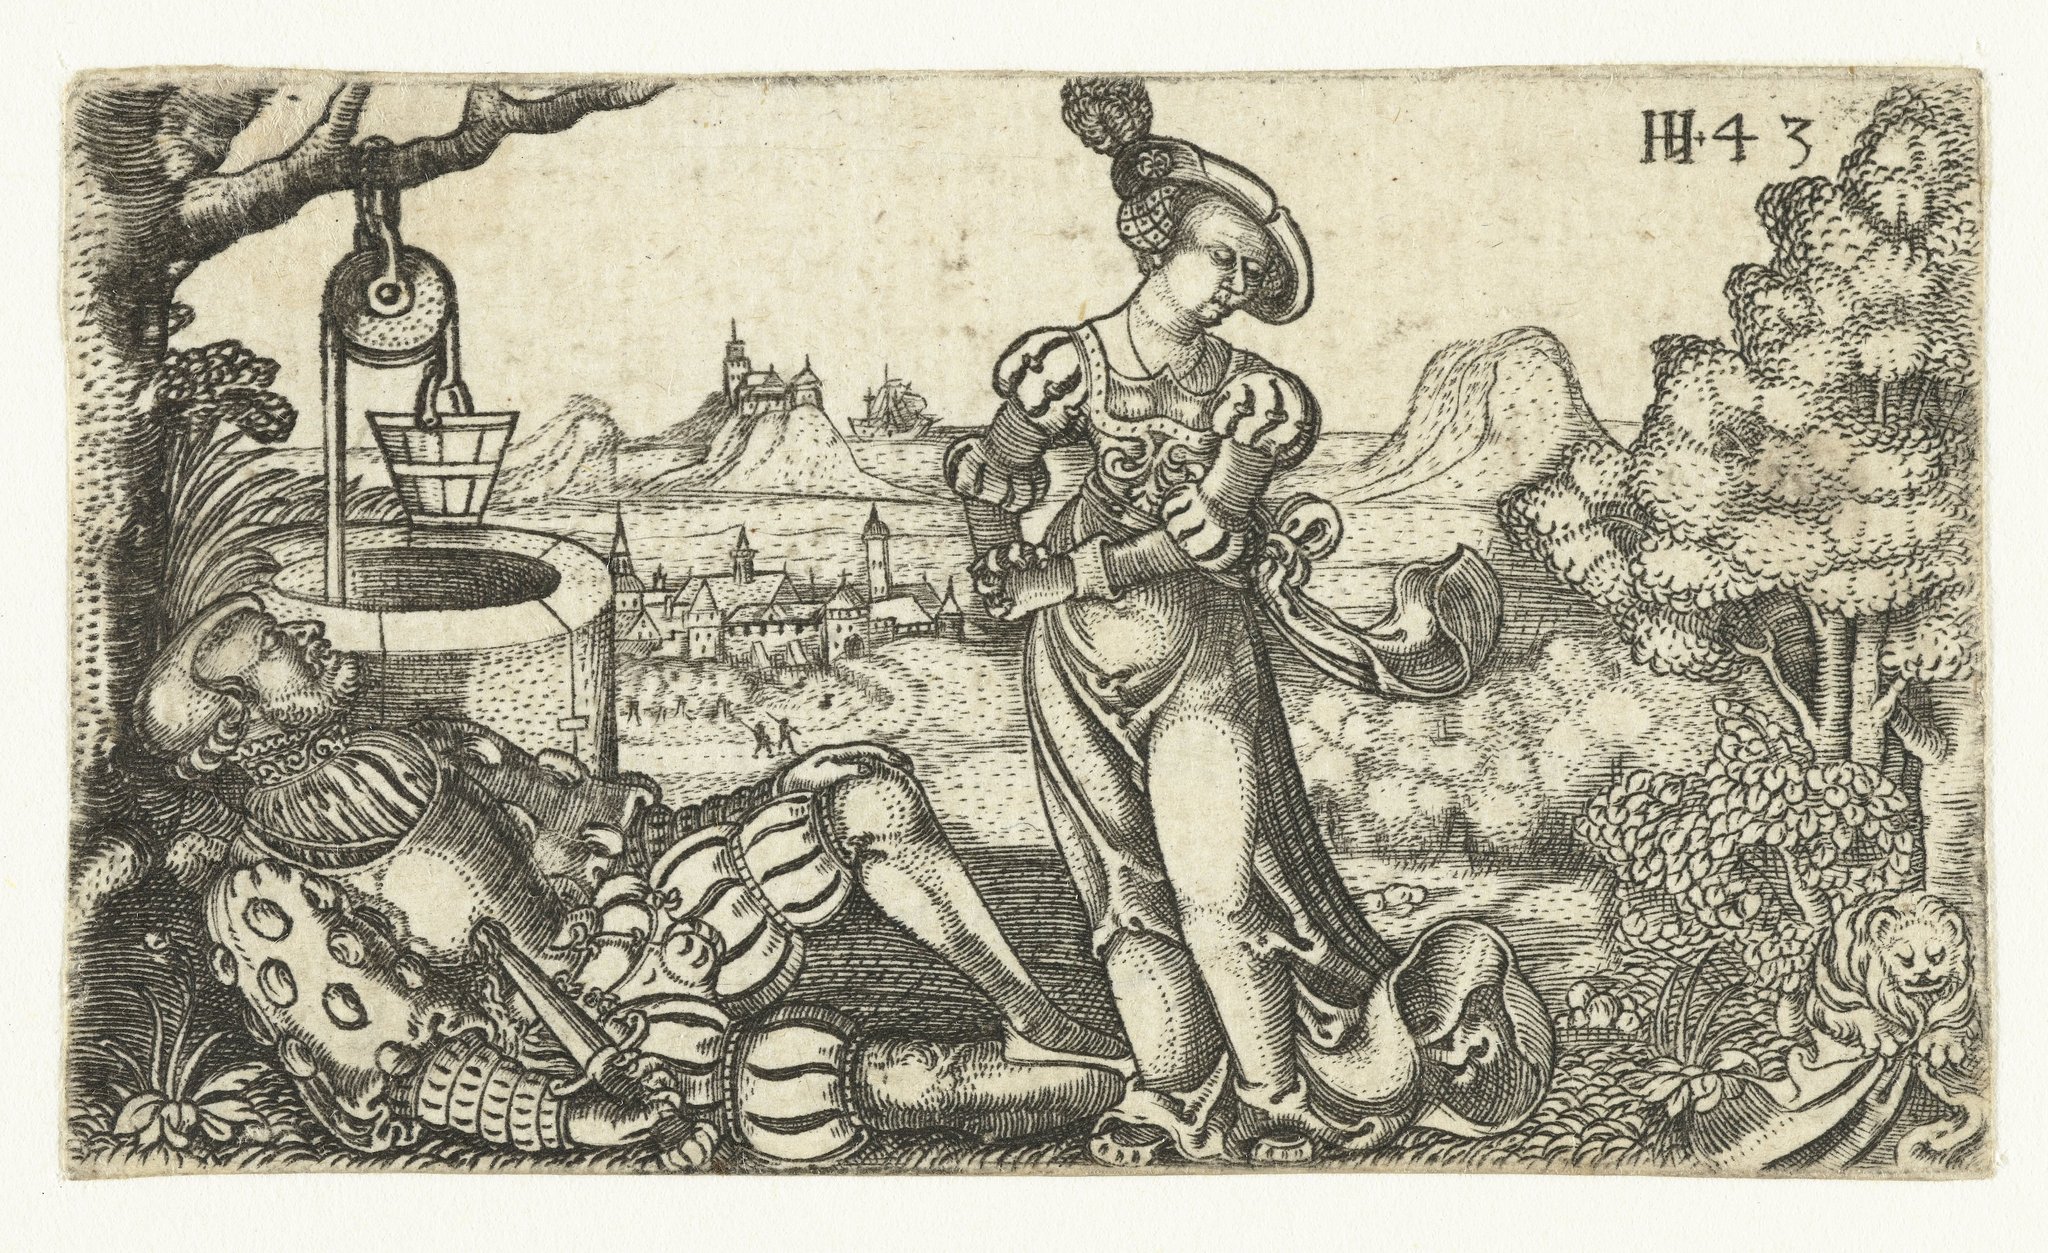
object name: print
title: Pyramus en Thisbe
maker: monogrammist hl (1543)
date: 1543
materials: paper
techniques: engraving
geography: germany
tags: thisbe kills herself with pyramus' sword (the scene may be represented near a fountain)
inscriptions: collector's mark: Lugt 2228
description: Thisbe treft haar geliefde Pyramus stervend aan naast een put. Hij heeft net zijn zwaard in eigen borst gestoken, na het zien van haar bebloede mantel in de klauwen van een leeuw.